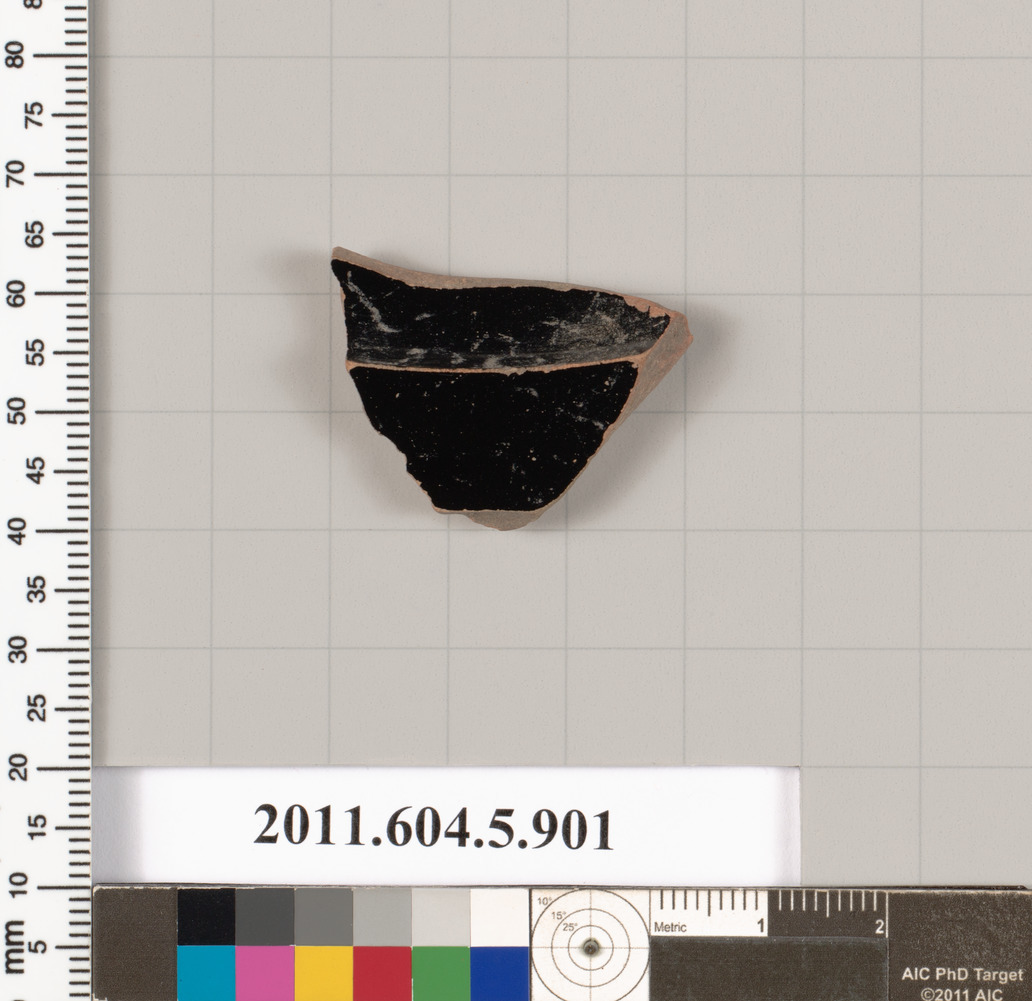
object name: kylix fragment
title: Terracotta fragment of a kylix (drinking cup)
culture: greek, attic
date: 600-401 BCE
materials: terracotta